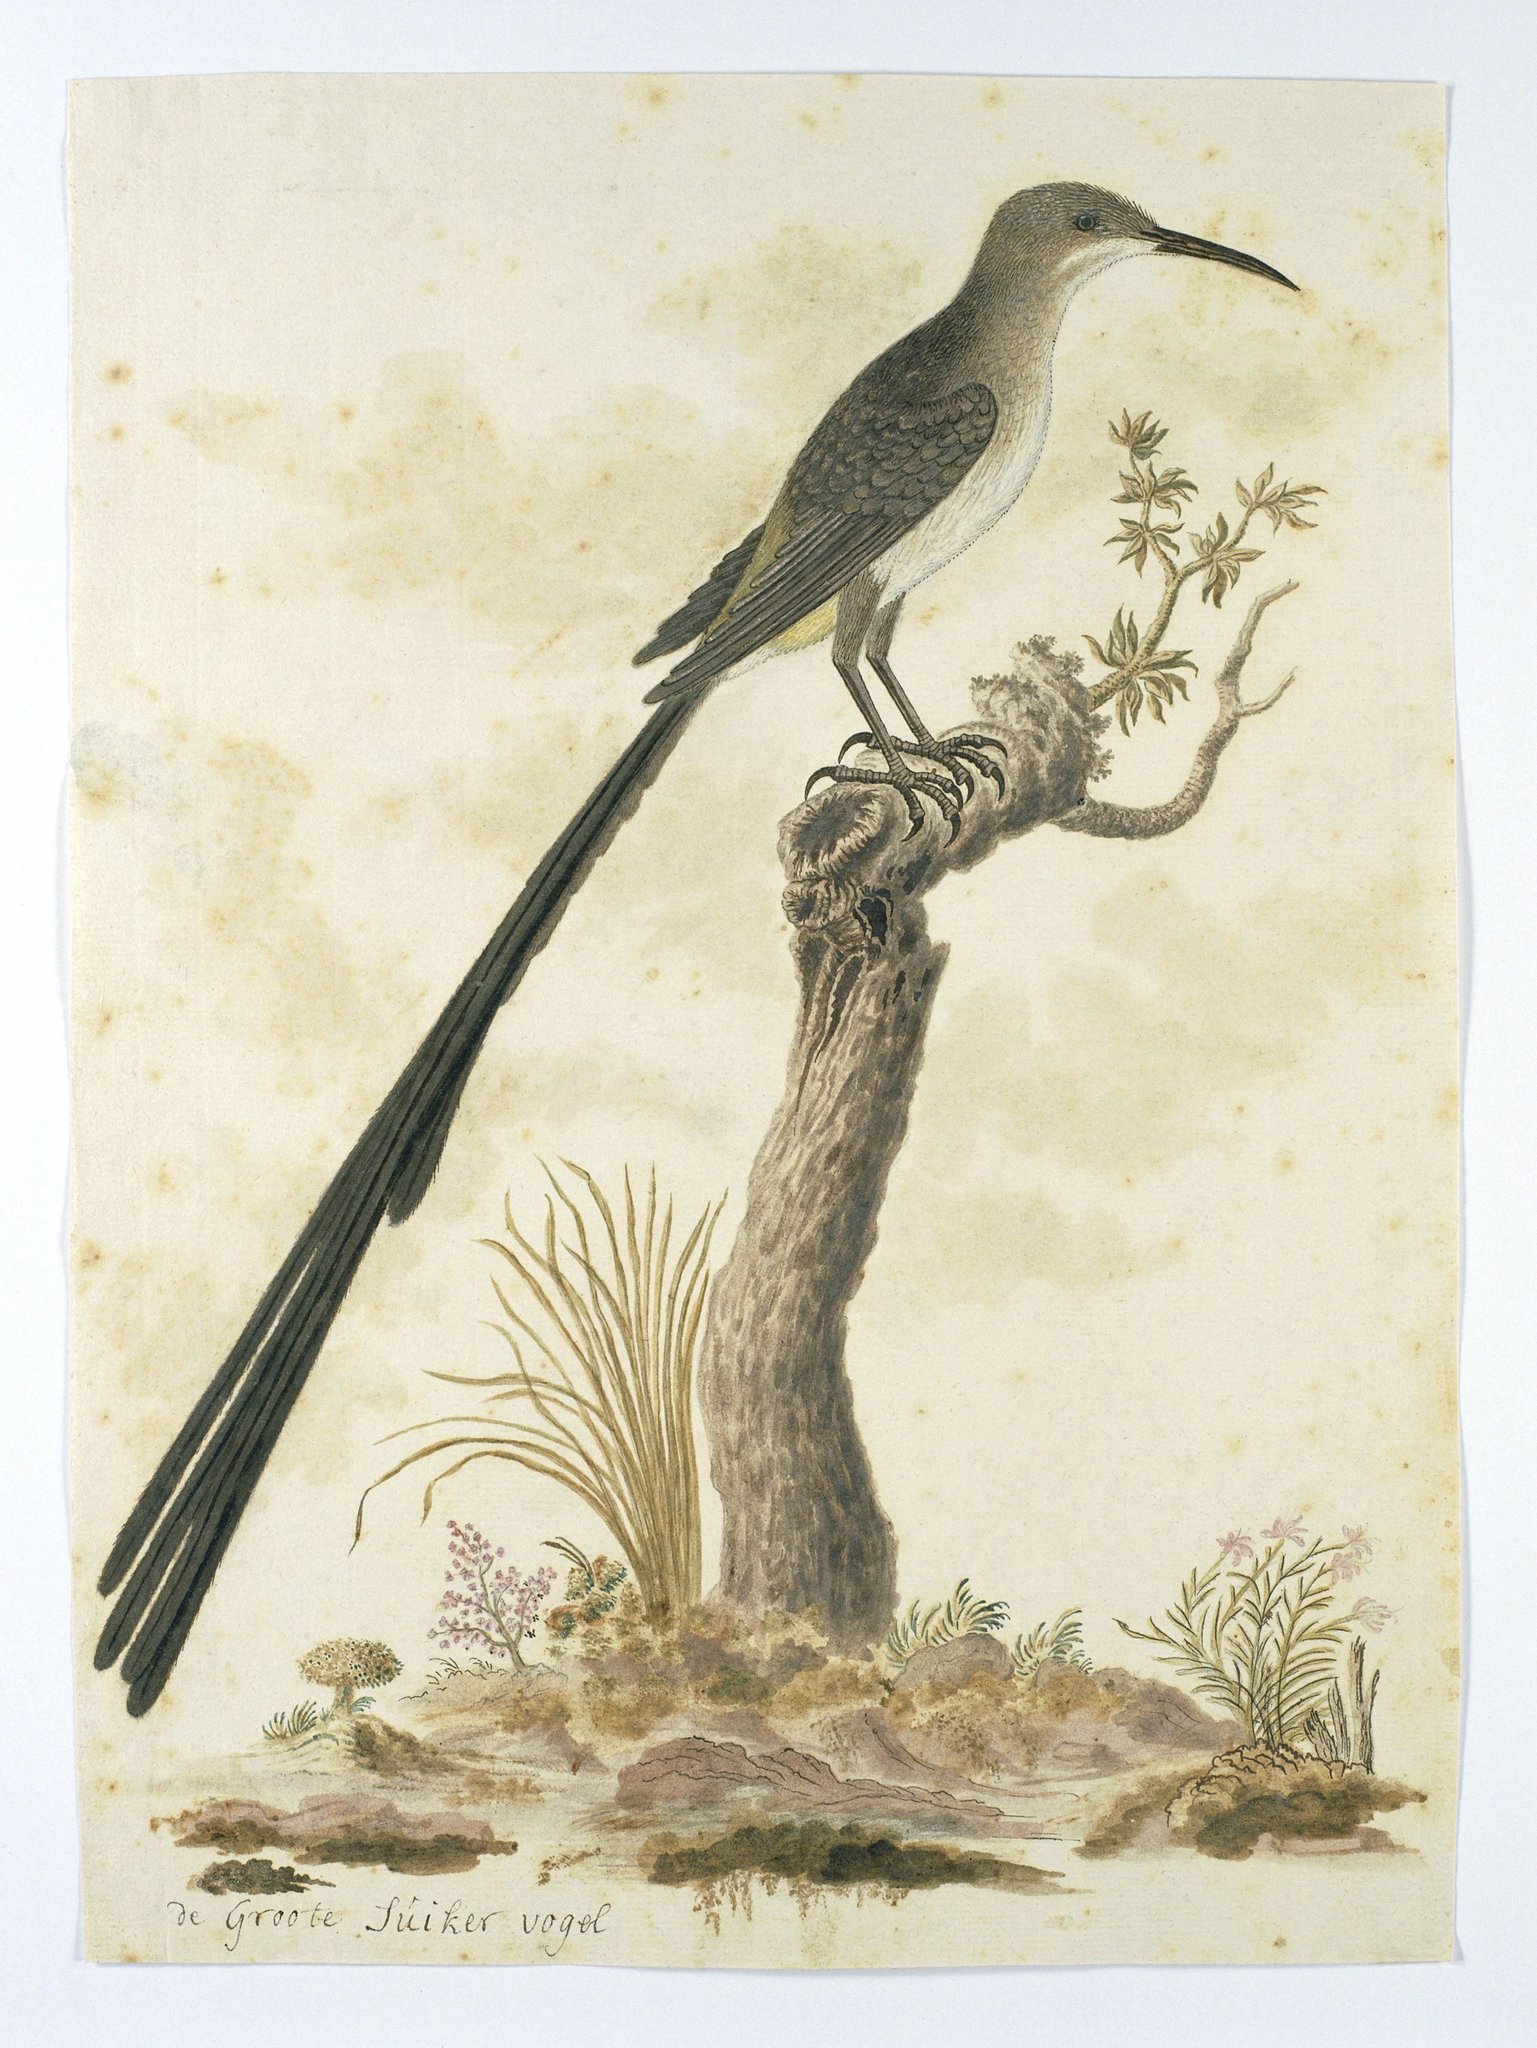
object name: album leaf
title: Promerops cafer (Cape sugarbird)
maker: robert jacob gordon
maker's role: draughtsman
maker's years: 1743-1795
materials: chalk, ink, paper, pencil, watercolor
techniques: brush, pen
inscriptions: annotation: ‘De Groote Suiker vogel’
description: Vogelstudie: Grote Kaapse suikervogel (Promerops cafer).